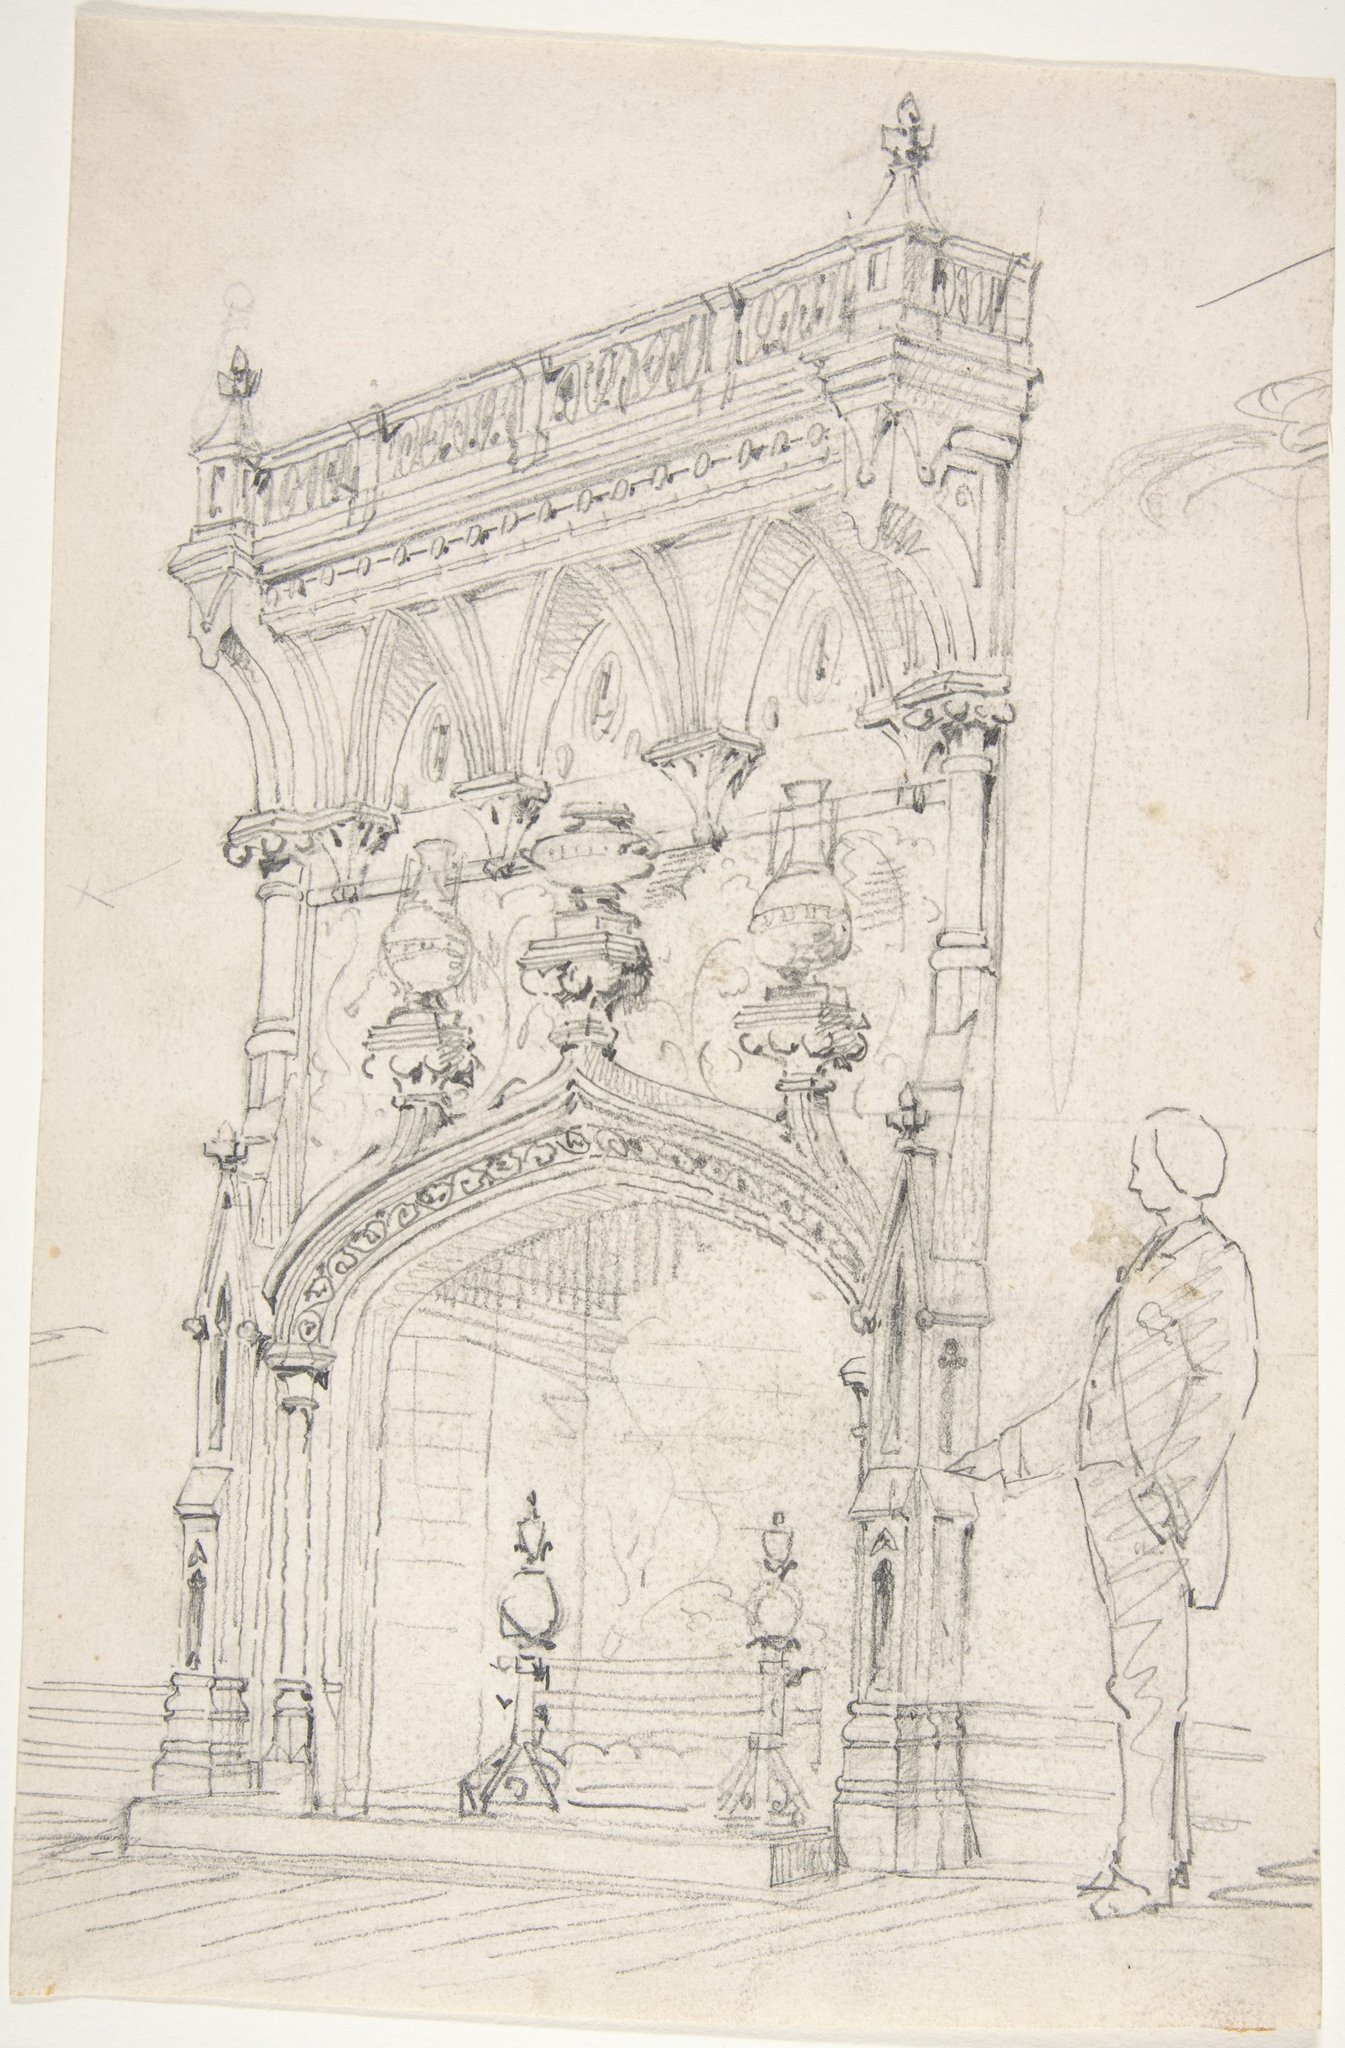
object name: drawing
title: Design for a Tall Chimneypiece, Decorated with Vases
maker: anonymous, british, 19th century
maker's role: artist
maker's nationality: british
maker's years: 1800-1900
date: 1801-1900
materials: graphite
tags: architecture,fireplaces